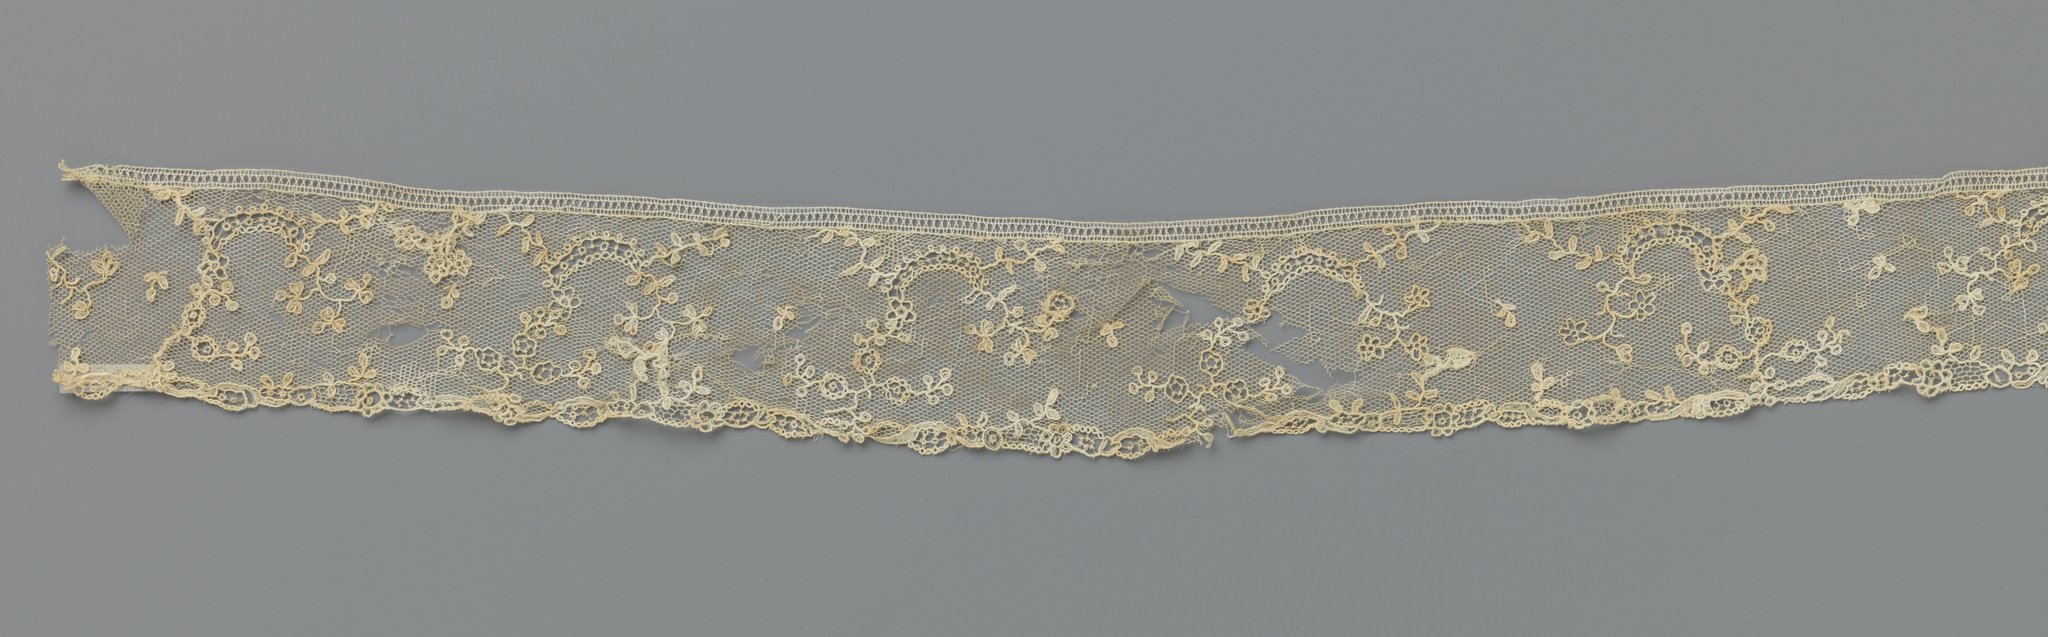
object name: strip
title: Strook applicatiekant met een rij boogjes en ijle takjes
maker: Anonymous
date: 1790-1799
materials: linen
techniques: lace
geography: brussels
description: Strook naturelkleurige Brusselse applicatiekant: naaldkant geappliceerd op drochelgrond. Het zich herhalende patroon bestaat uit een rij opengewerkte boogjes met ijle rankjes aan de uiteinden. Aan de onderzijde van de strook ontspringen ijle takjes met steeds drie opengewerkte ronde bloempjes, die tot aan de boogjes reiken. Tussen de boogjes door staan enkele gestrooide bloempjes. Het spaarzame volwerk wordt omsloten door wijd gefestoneerde draadbundels. De bovenzijde is afgewerkt met een apart geklost bandje. De vrijwel recht afgewerkte onderzijde is voorzien van zeer fijne picots.